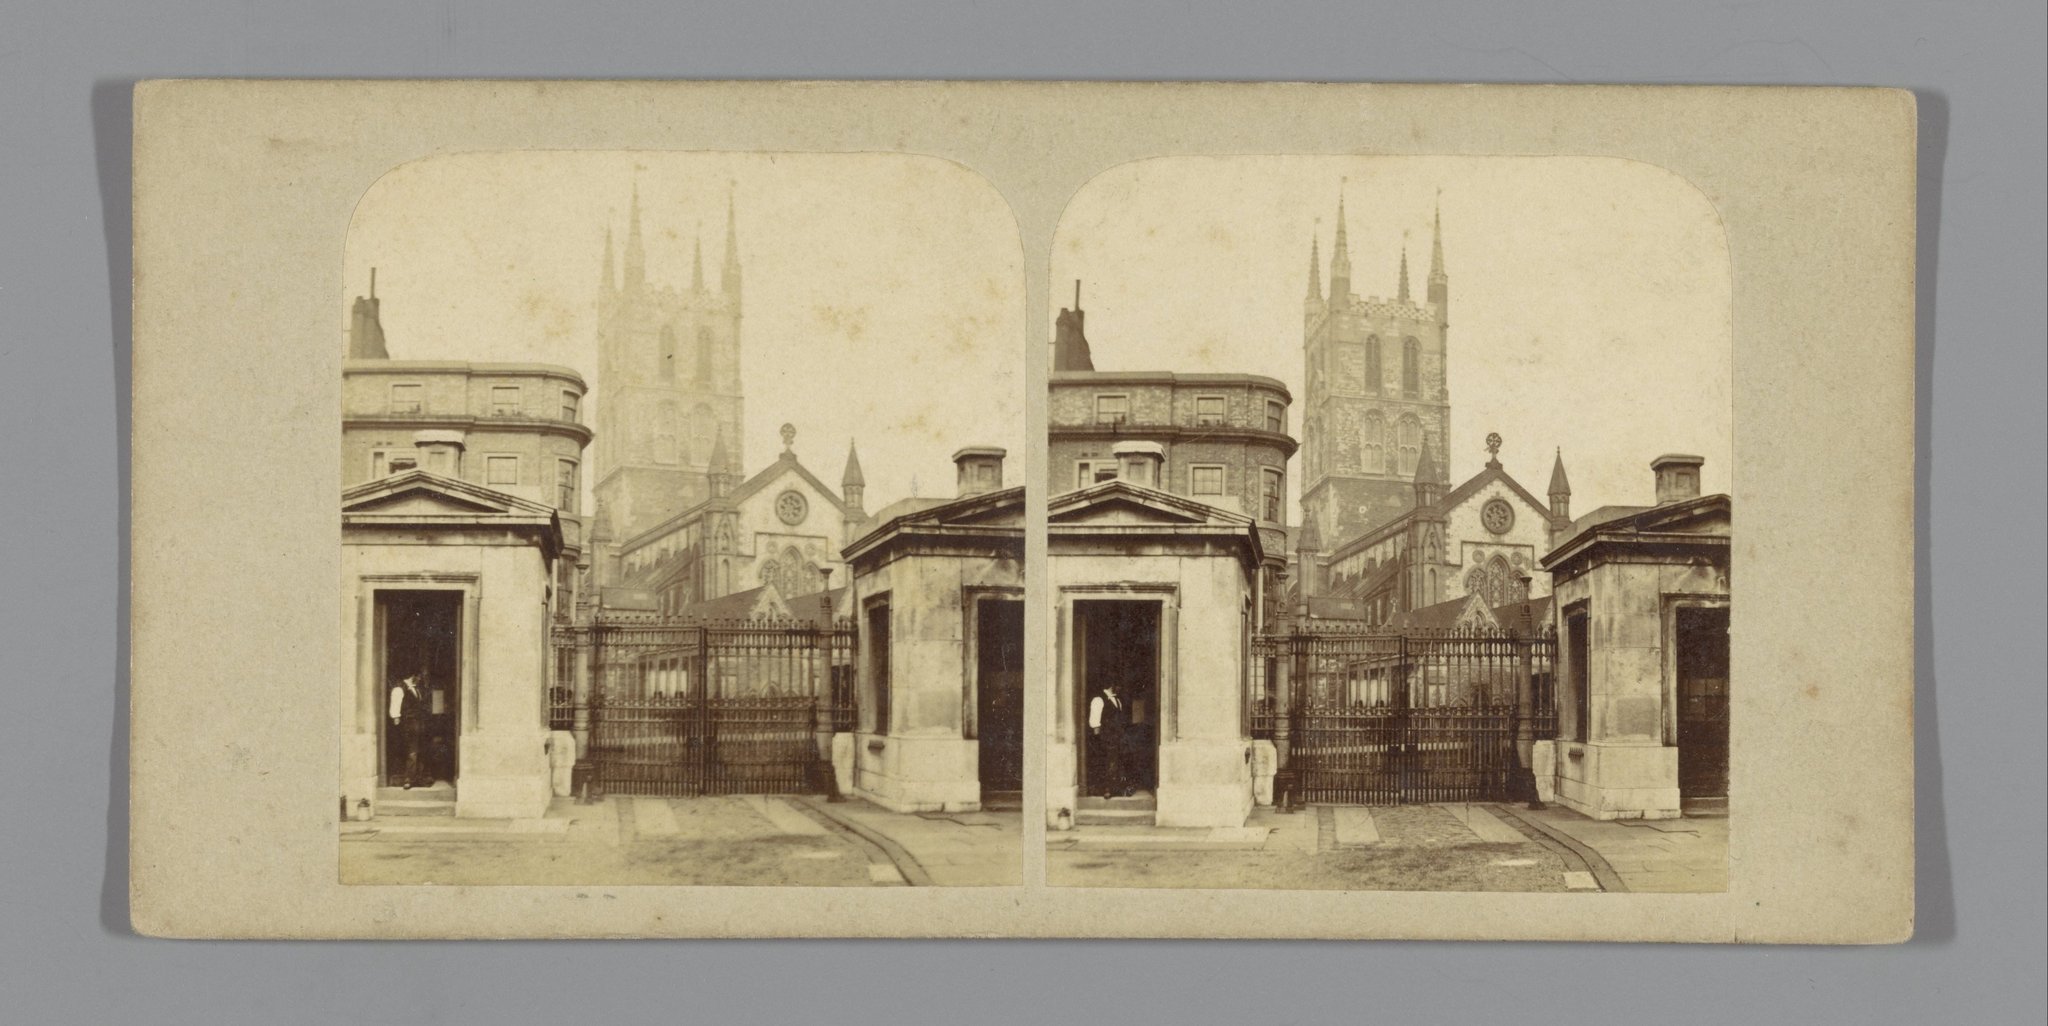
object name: stereograph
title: Gezicht op de kathedraal van Southwark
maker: Anonymous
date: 1850-1880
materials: cardboard, photographic support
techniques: albumen print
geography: london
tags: church (exterior)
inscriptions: number: ‘10 Sy[...] 95’, number: ‘7.’